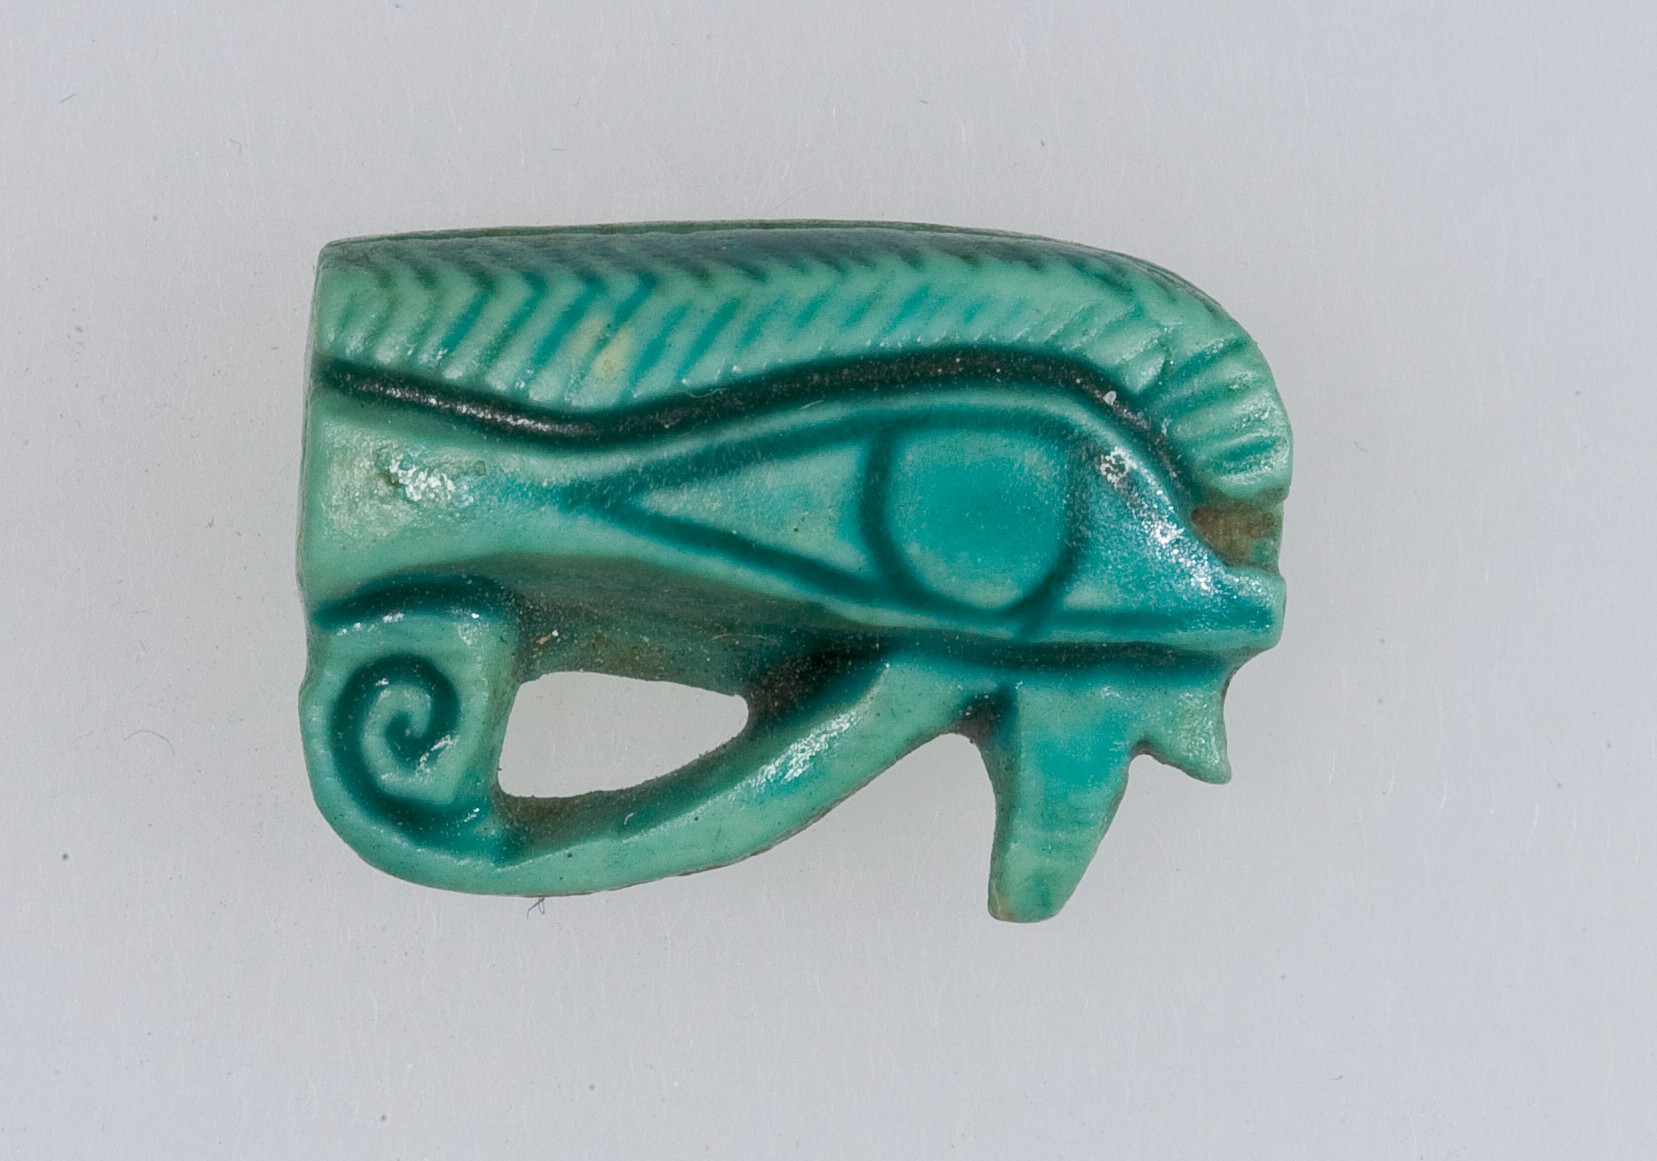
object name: wedjat eye, thutmose iv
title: Stamp Seal in the Shape of Wedjat-Eye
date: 1400-1390 BCE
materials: stone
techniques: glazing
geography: egypt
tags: eyes